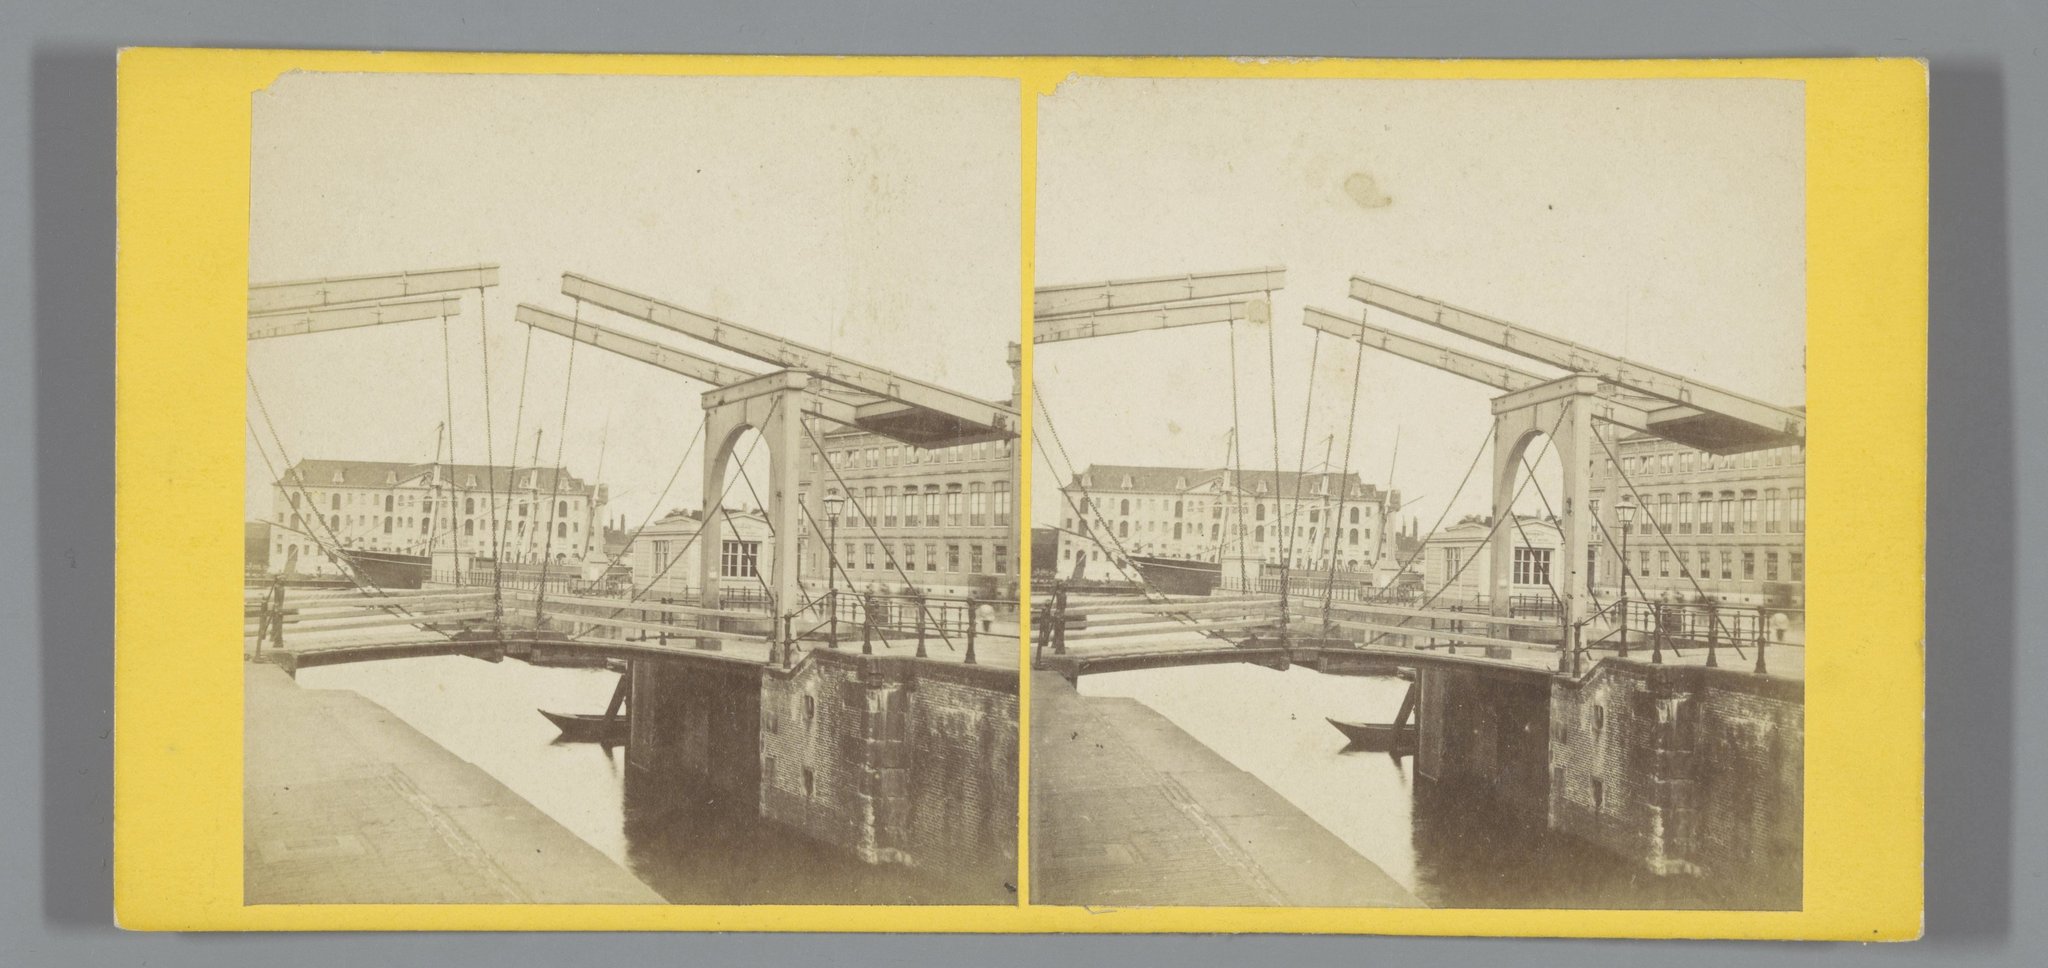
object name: stereograph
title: Gezicht op het gebouw van de marine in Amsterdam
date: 1860-1885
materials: cardboard, photographic support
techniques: albumen print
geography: amsterdam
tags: bridge, amsterdam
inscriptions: inscription: ‘HET MARINEGEBOUW/ TE/ Amsterdam./ A. JAGER, WATER 110, TE AMSTERDAM.’